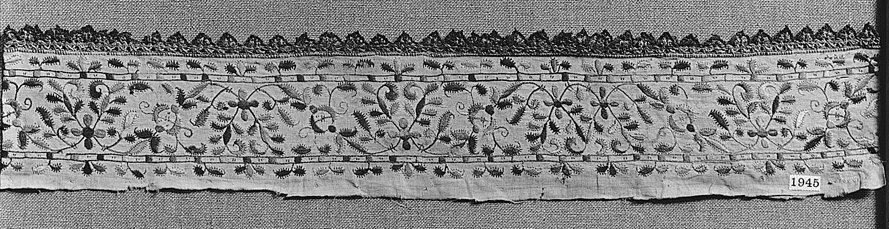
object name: border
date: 1501-1600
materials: linen, silk